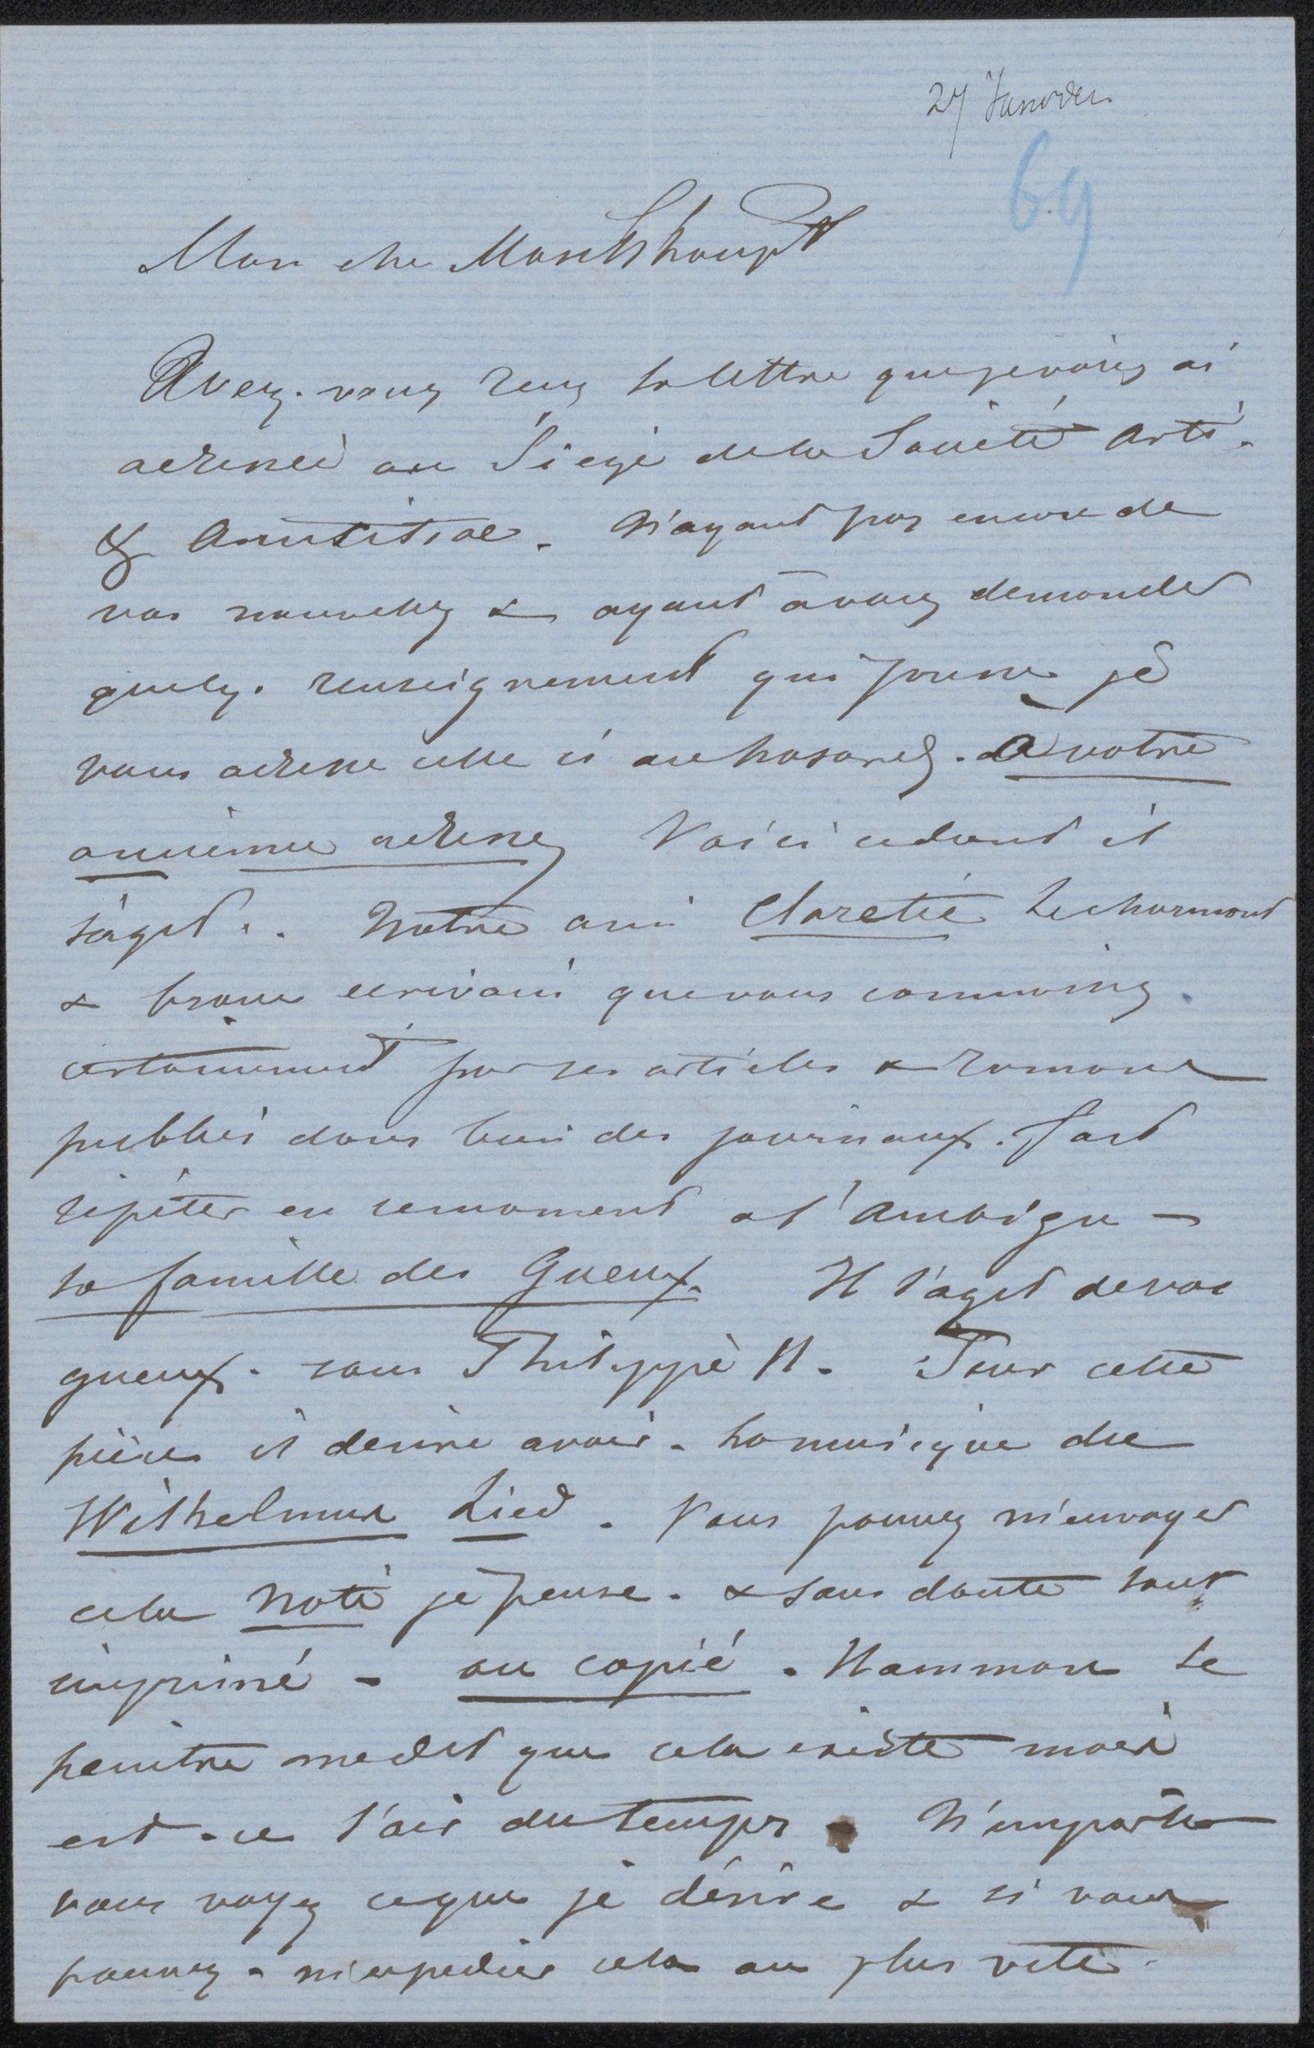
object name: letter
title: Brief aan Jan Hendrik Maschaupt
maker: adolphe mouilleron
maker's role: draughtsman, print maker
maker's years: 1820-1881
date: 1836-1881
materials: ink, paper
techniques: pen, writing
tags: paris, edouard hamman, amsterdam, painter, jan hendrik maschaupt, leiden, print maker, draughtsman, rembrandt van rijn, painting (including book-illumination, miniature-painting)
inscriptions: collector's mark: ‘RPK’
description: Brief gedateerd 27 januari 69 in latere hand.